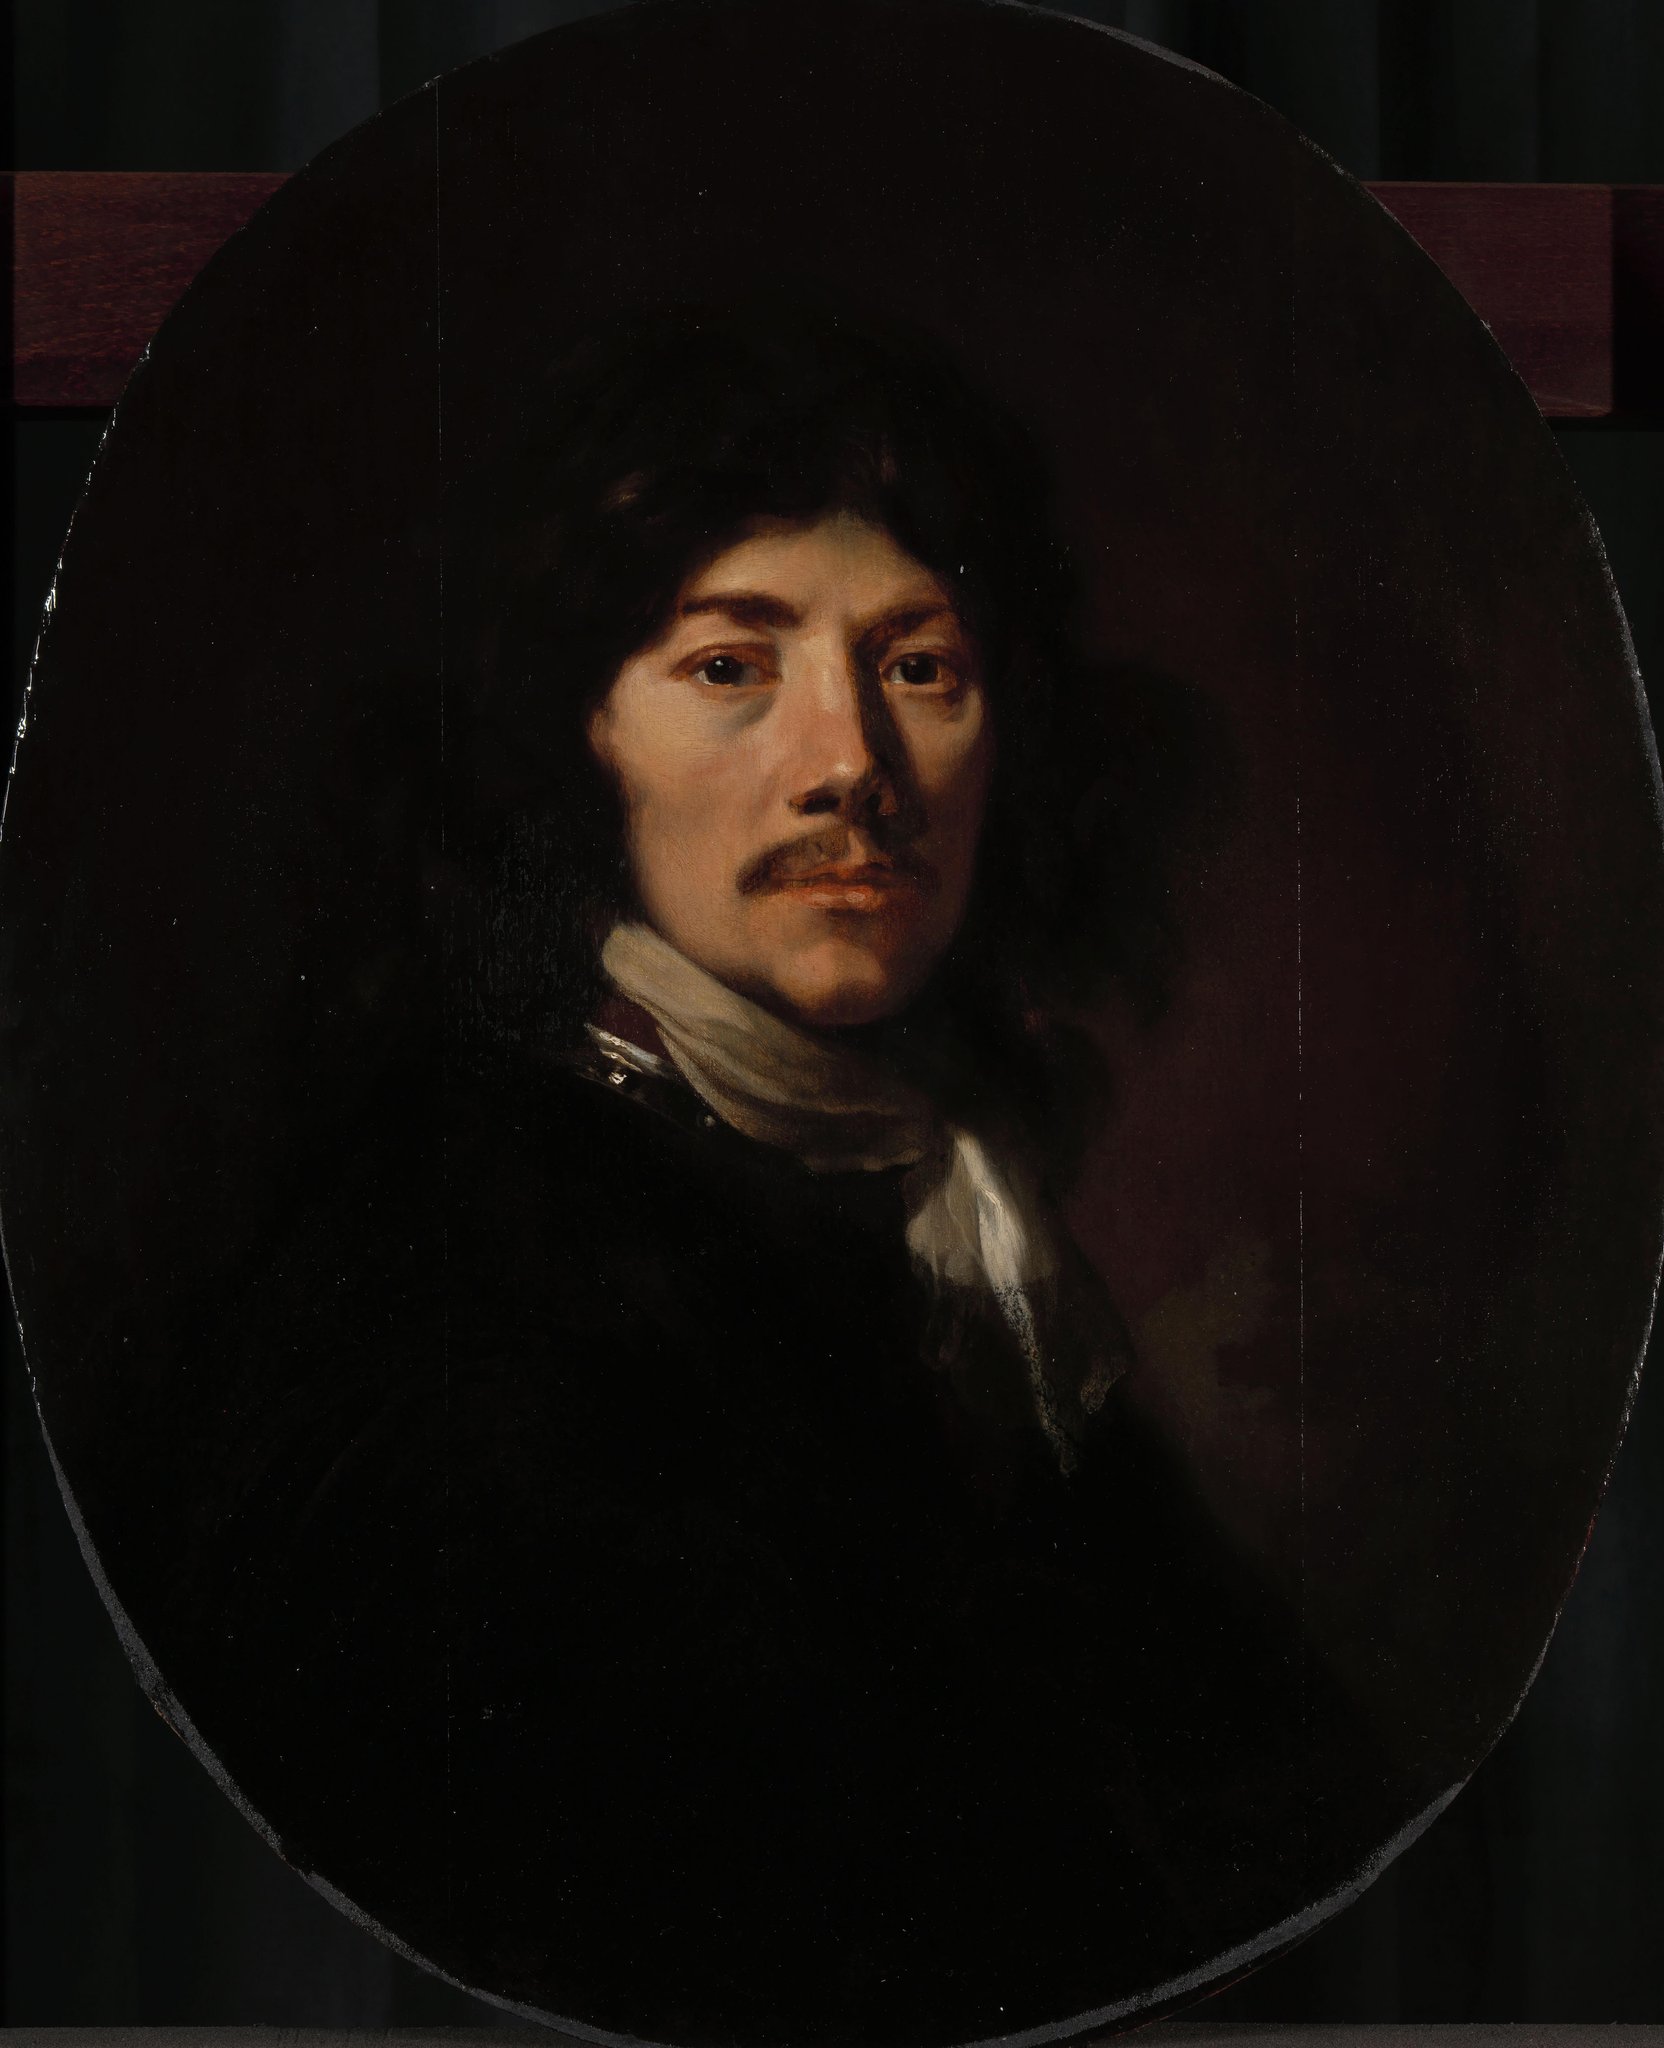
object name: painting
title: Bust of a Man with a Gorget, possibly a Self-Portrait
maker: jacob van loo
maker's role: painter, print maker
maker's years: 1614-1670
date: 1655-1665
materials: oil, panel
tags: paris, painter, print maker, jacob van loo, portrait, self-portrait of artist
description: Mogelijk een zelfportret van Jacob van Loo. Borststuk, in ovaal met halsberg en witte halsdoek.